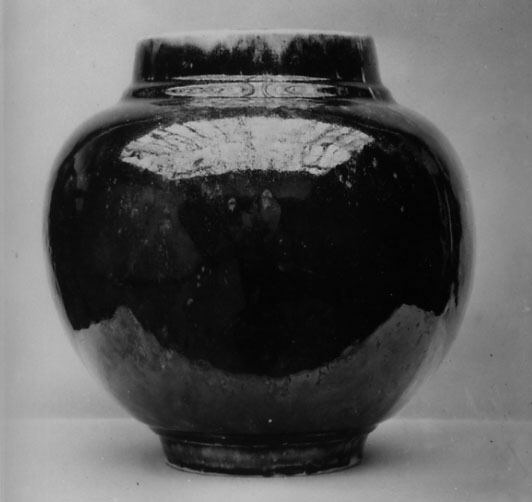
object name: vase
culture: french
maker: ernest chaplet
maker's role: designer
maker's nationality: french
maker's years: 1835-1909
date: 1890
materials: porcelain